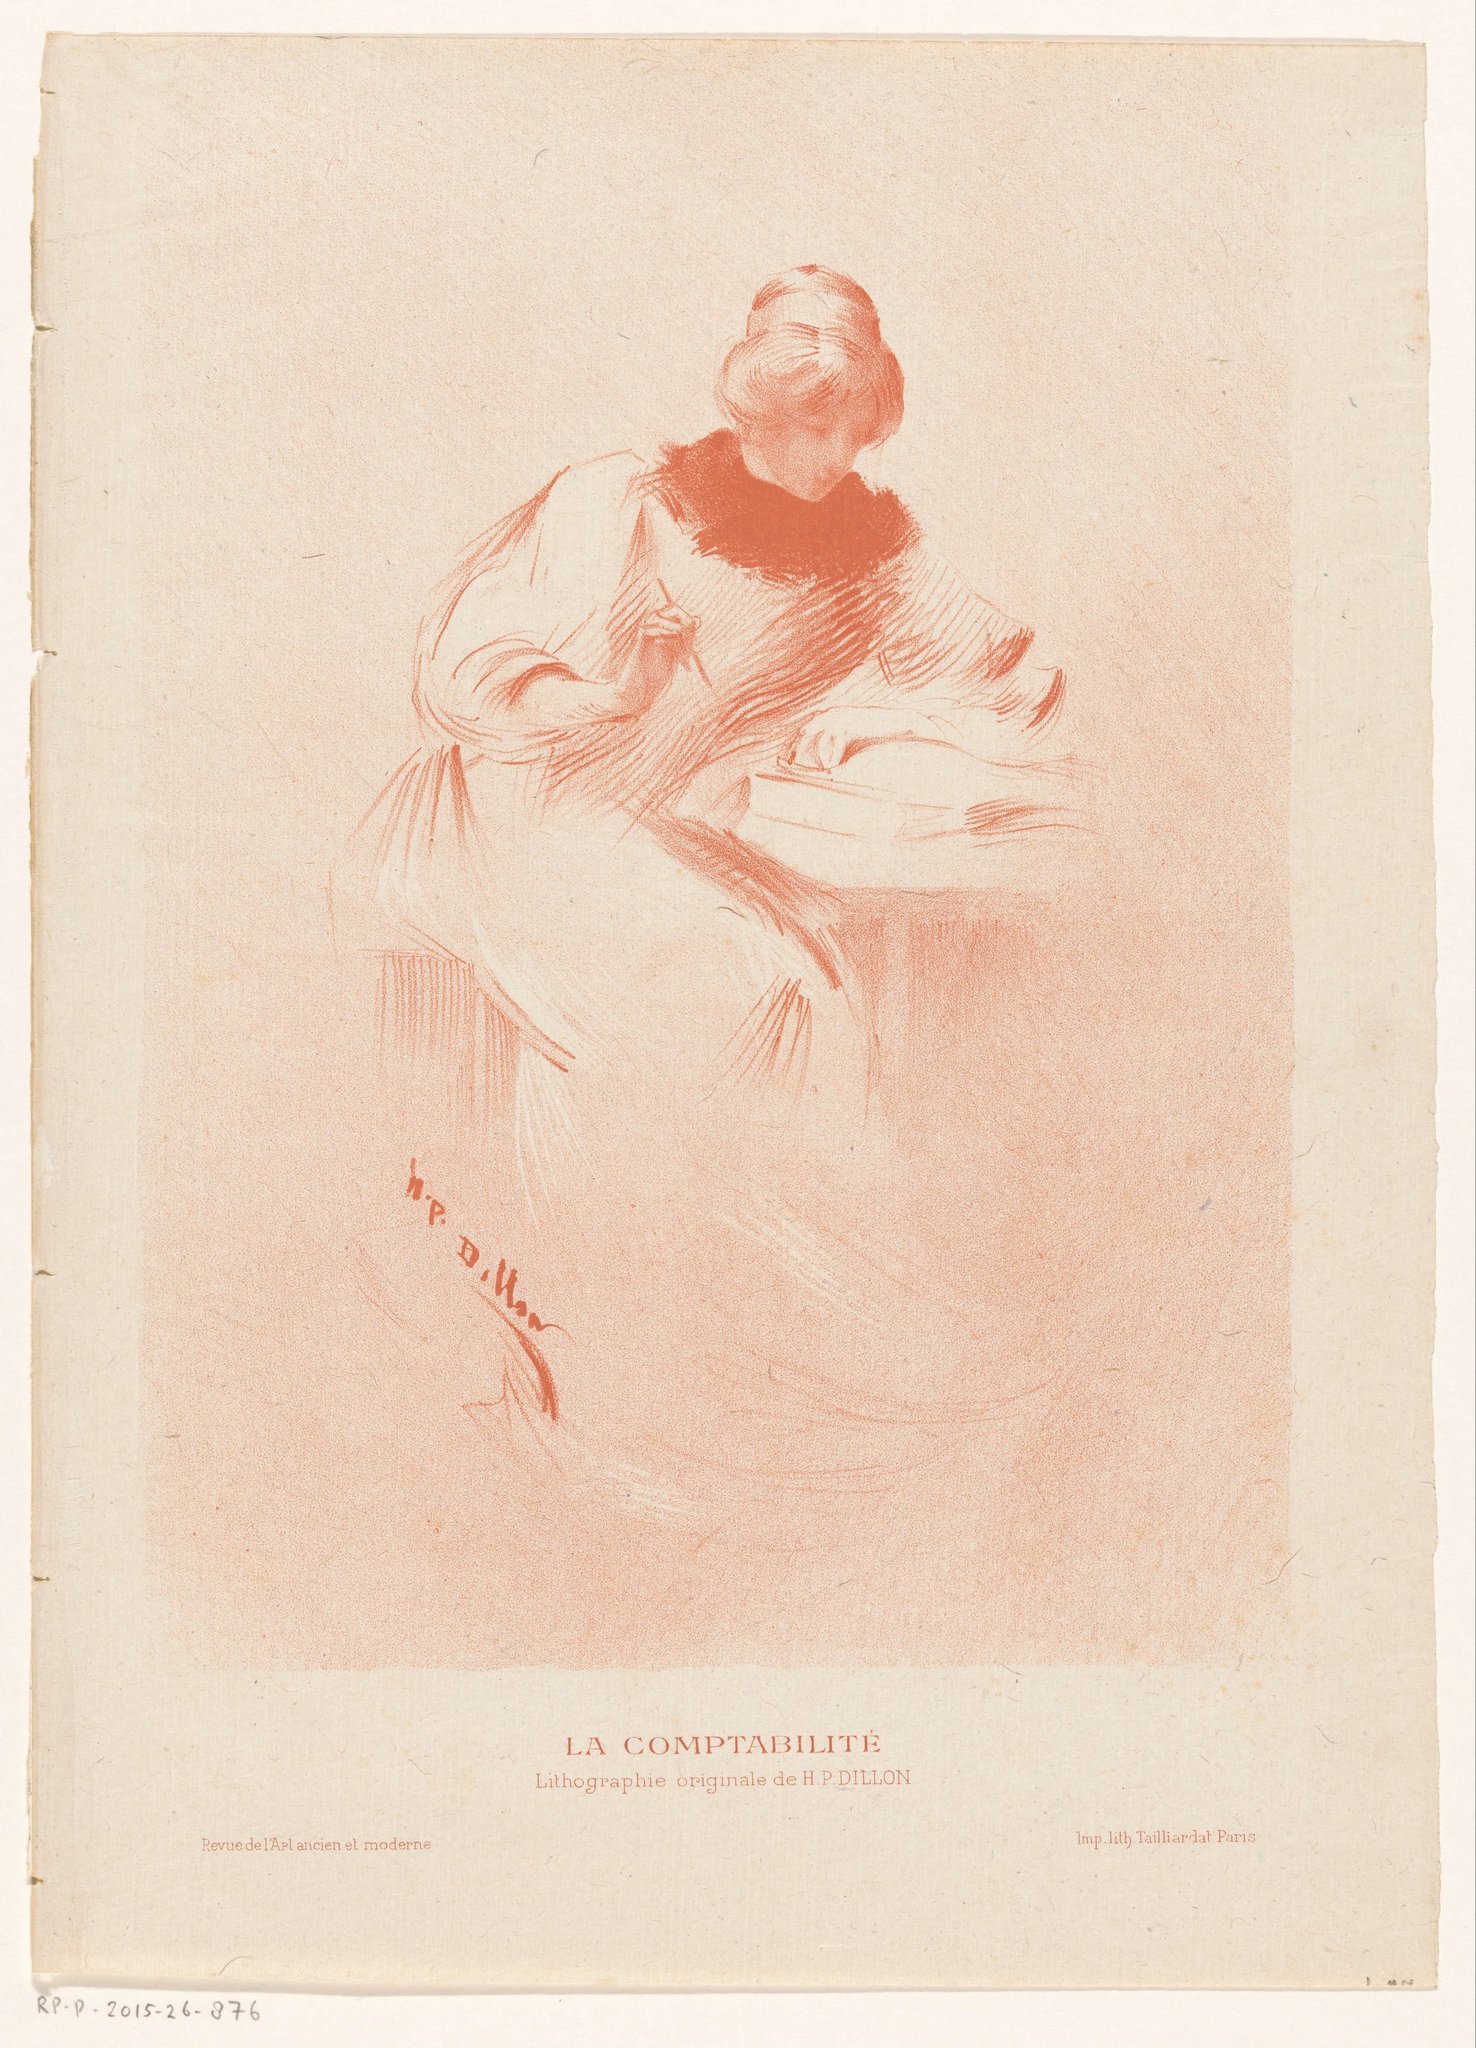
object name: print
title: La comptabilité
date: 1884-1892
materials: paper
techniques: lithograph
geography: paris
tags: book-keeping, accountant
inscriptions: collector's mark: Lugt 2228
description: Prent afkomstig uit: Revue de l'Art français ancien et moderne, uitgegeven tussen 1884-1892.